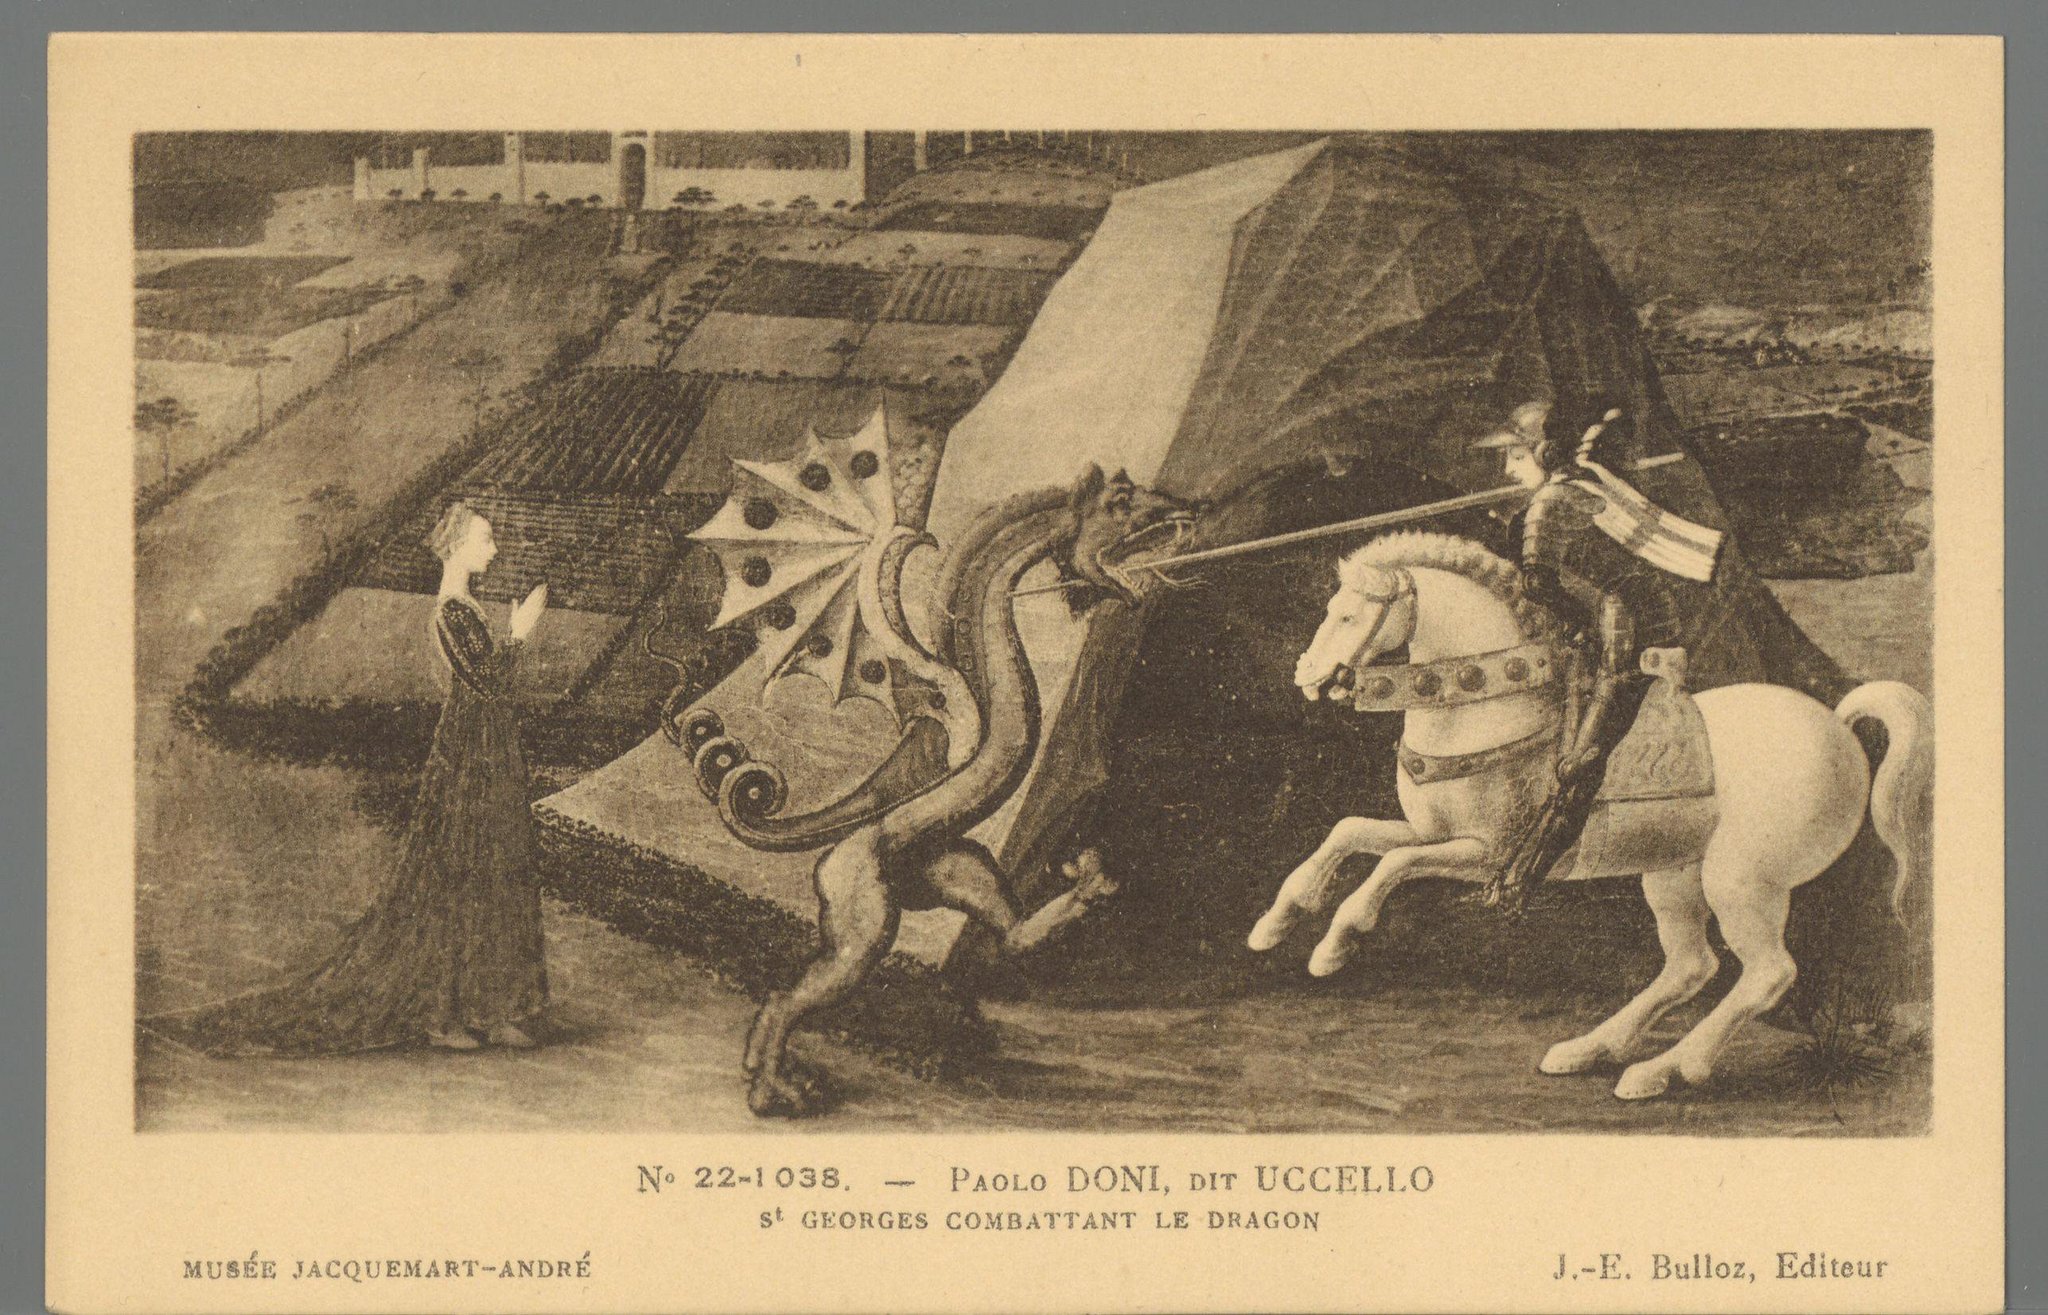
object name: ansichtkaart, prentbriefkaart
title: Paolo Doni, dit Uccello. St Georges combattant le dragon. Musée Jacquemart-André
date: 1903-1930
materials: cardboard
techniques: photograph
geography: paris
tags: permanent exhibition, museum, picture, painting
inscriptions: collector's mark: ‘AFE v S’